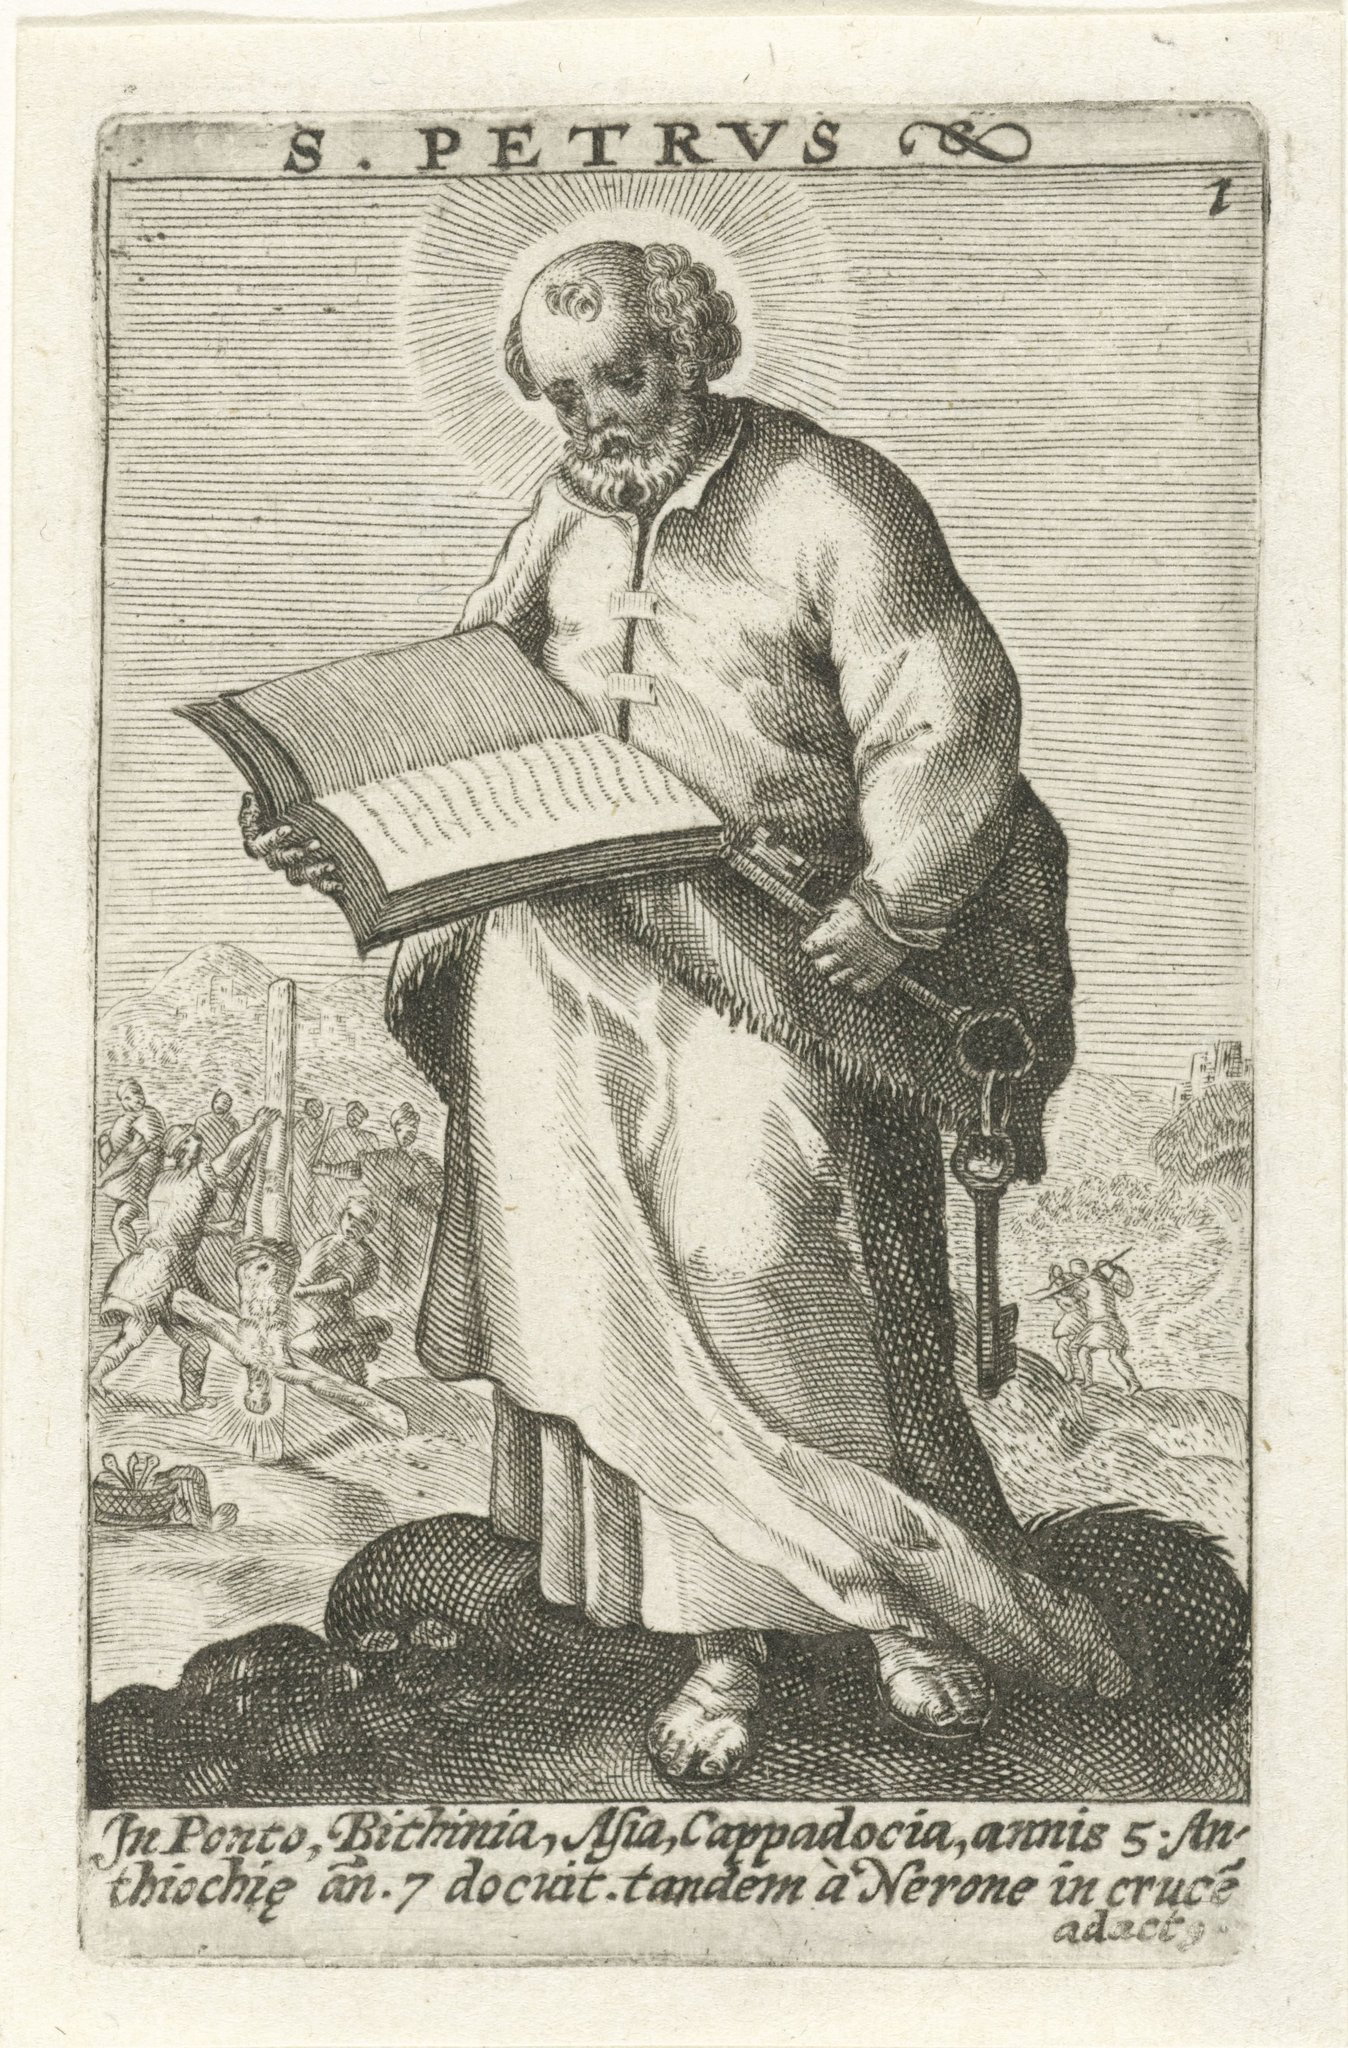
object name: print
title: De twaalf apostelen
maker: crispijn van de passe (i)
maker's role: draughtsman, print maker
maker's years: 1564-1637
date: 1574-1637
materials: paper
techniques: engraving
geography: cologne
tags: peter crucified upside down, the apostle peter, first bishop of rome; possible attributes: book, cock, (upturned) cross, (triple) crozier, fish, key, scroll, ship, tiara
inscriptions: collector's mark: Lugt 240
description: De apostel Petrus, ten voeten uit, met een sleutel en een boek in zijn handen. Op de achtergrond zijn kruisiging. In de marge een onderschrift in het Latijn. Prent uit een serie met de twaalf apostelen.